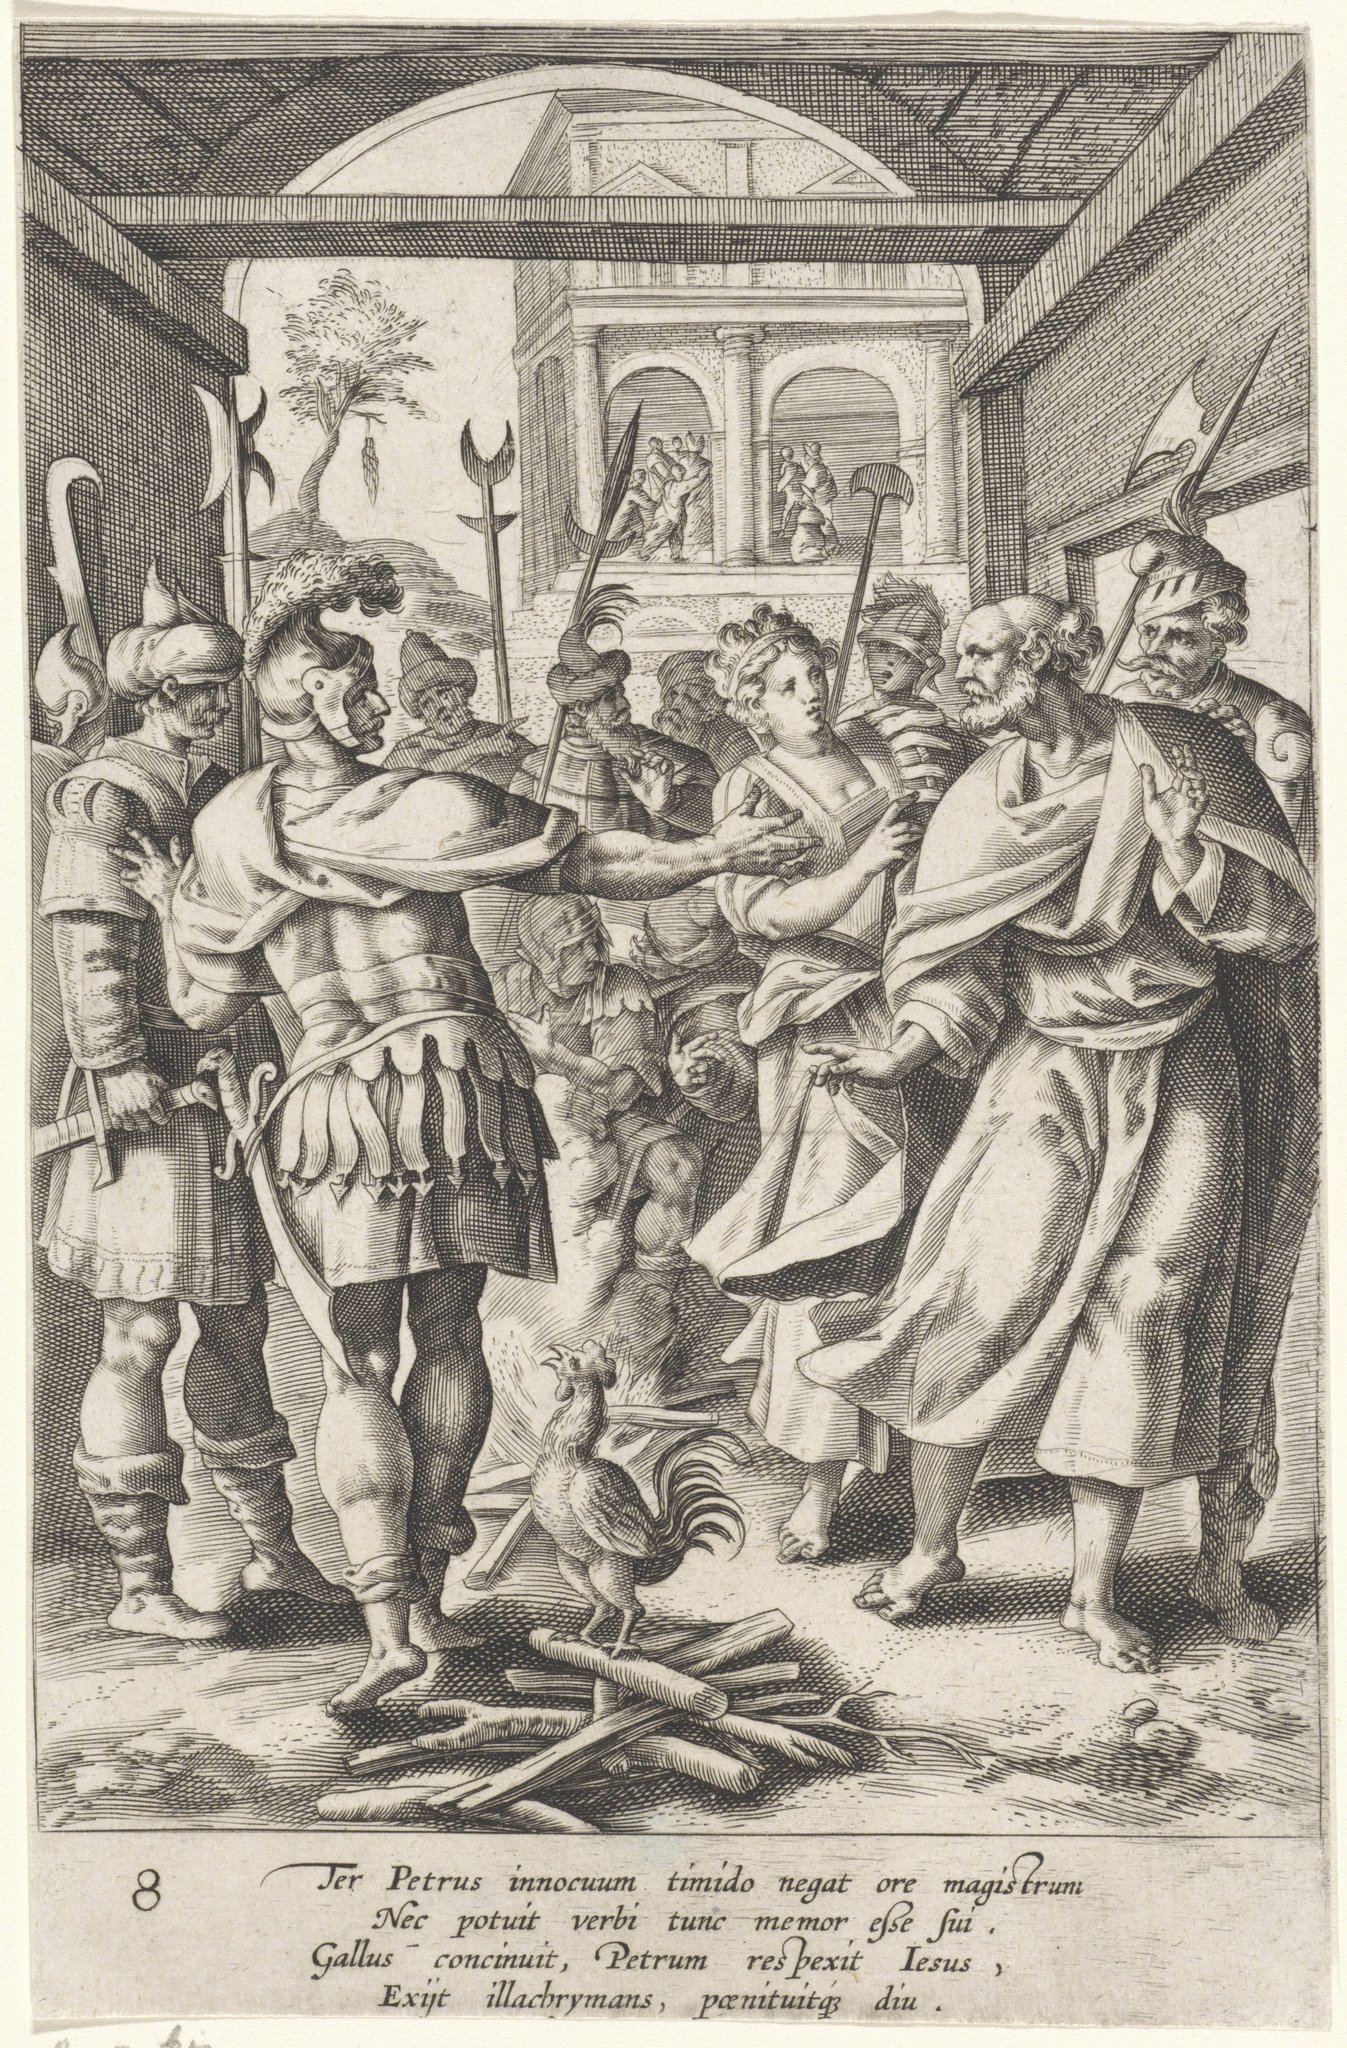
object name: print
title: Leven en passie van Christus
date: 1583-1587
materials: paper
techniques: engraving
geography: antwerp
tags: peter denies christ, usually before a girl-servant and some soldiers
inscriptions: collector's mark: Lugt 2228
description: Prent gebruikt in: Thesaurus sacrarum historiaru[m] veteris (et novi) testame[n]ti, elega[n]tissimis imaginibus expressu[m] excelle[n]tissimoru[m] in hac arte viroru[m] opera : nu[n]c primu[m] in luce[m] editus. Antwerpen: Gerard de Jode, 1585.